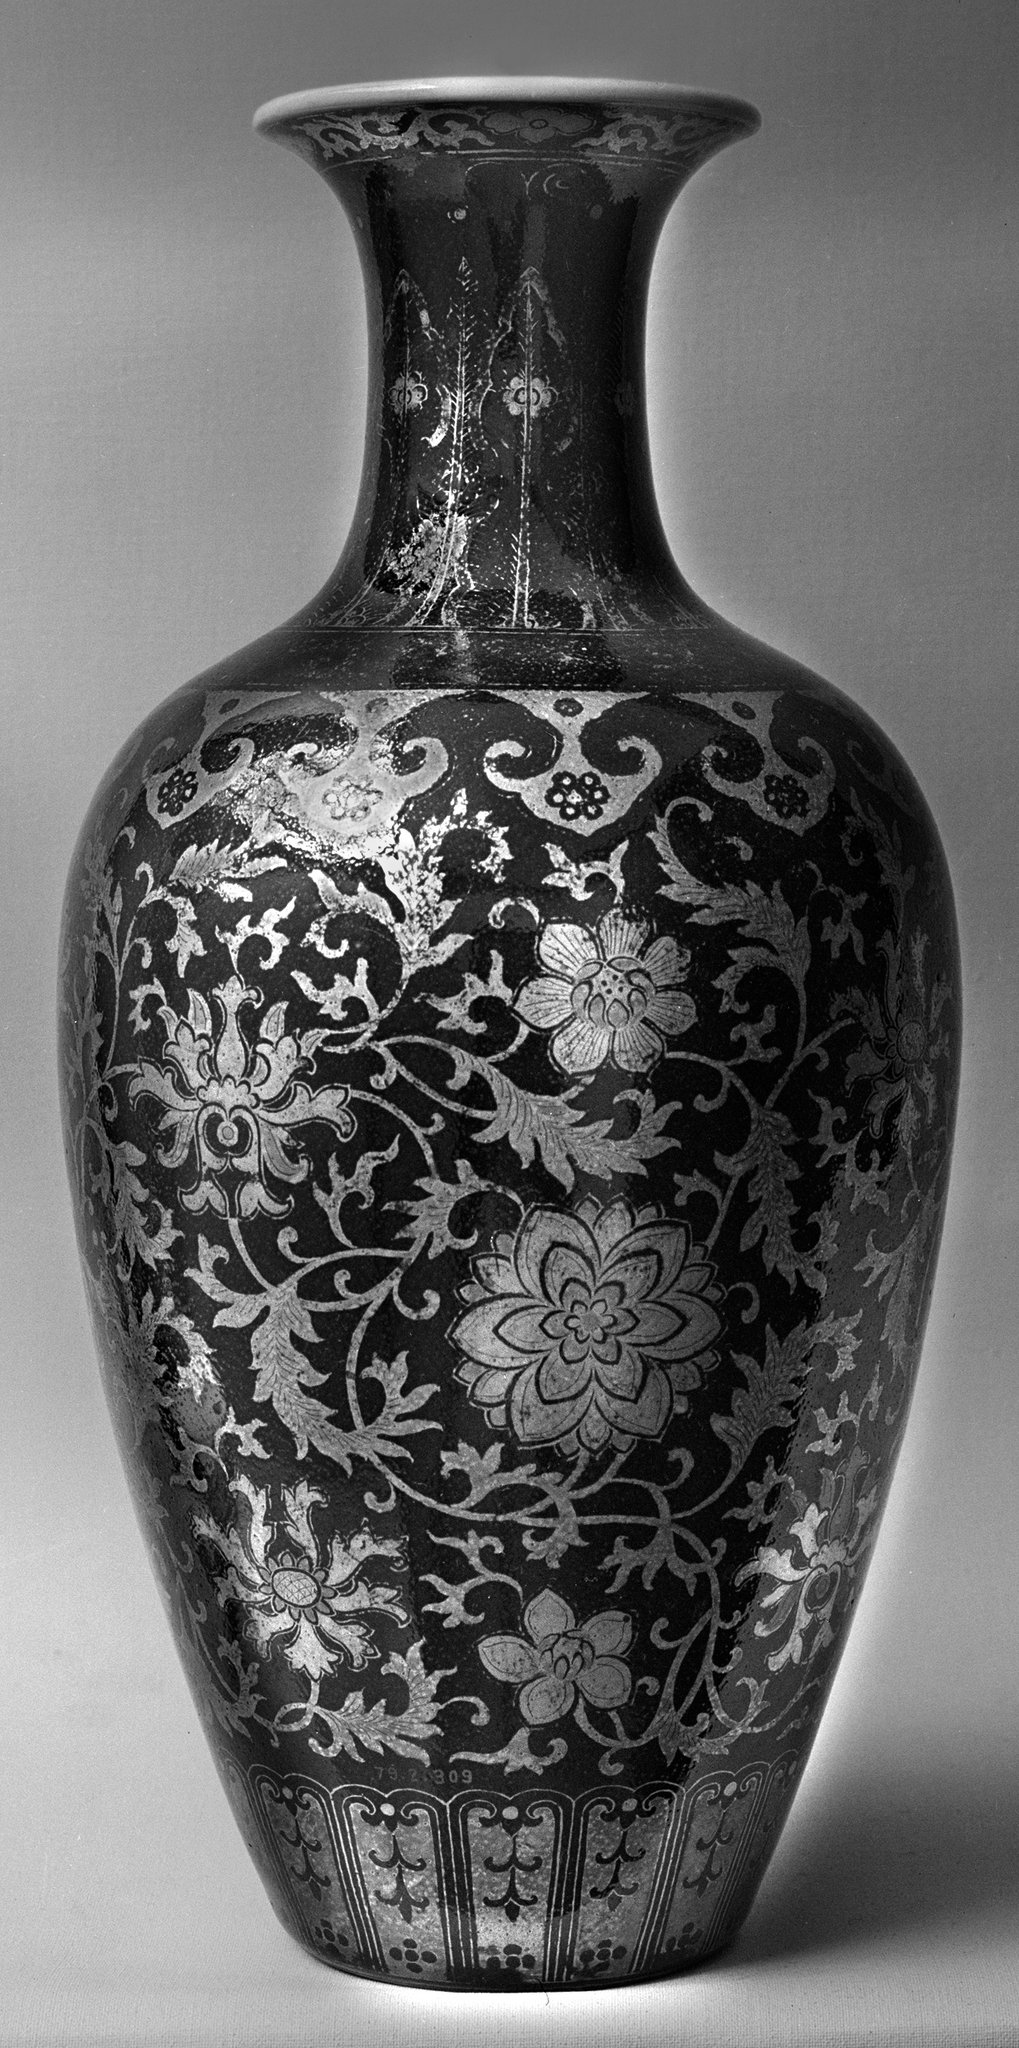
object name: vase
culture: chinese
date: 1736-1795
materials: gilt, glaze, porcelain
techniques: painting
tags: flowers